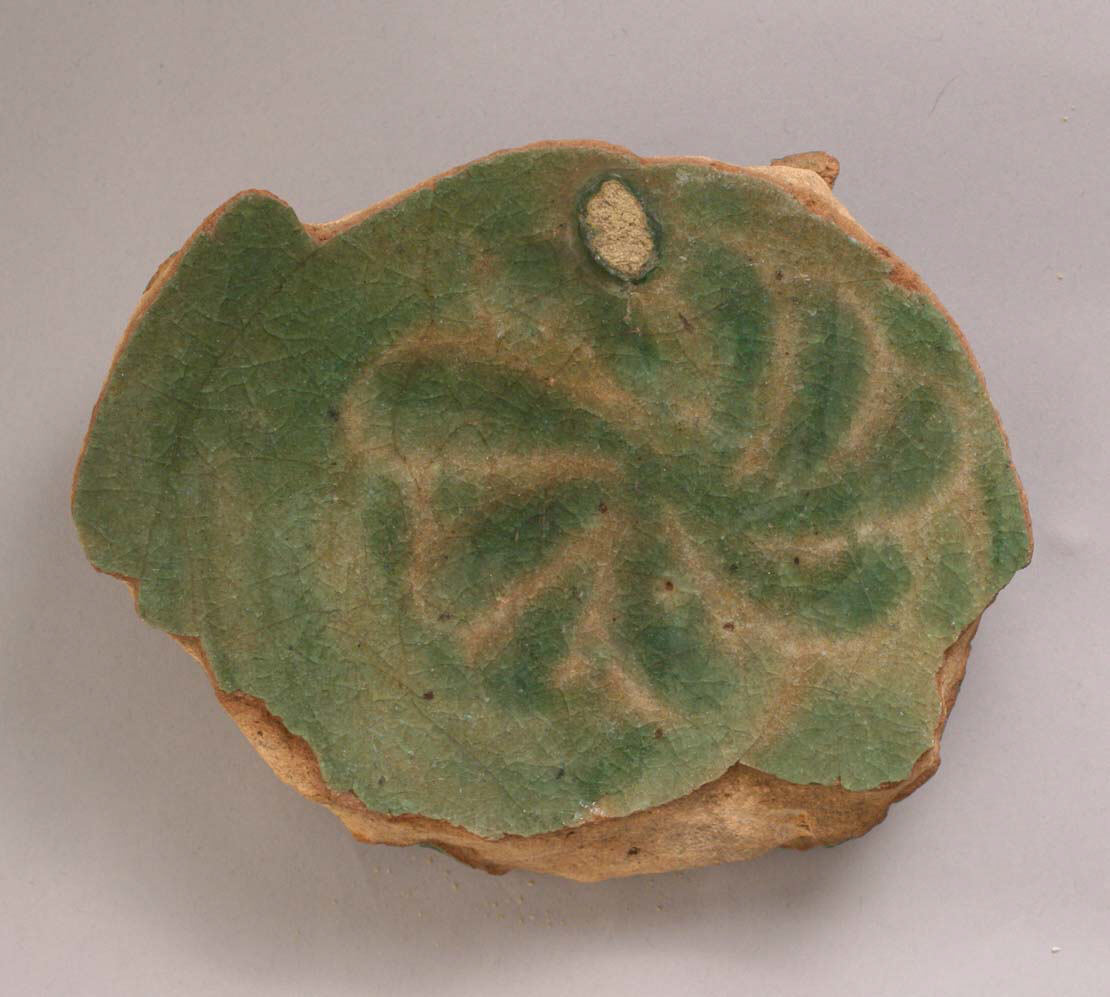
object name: ceramic fragment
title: Fragment of a Bowl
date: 1301-1500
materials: earthenware, glaze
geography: egypt